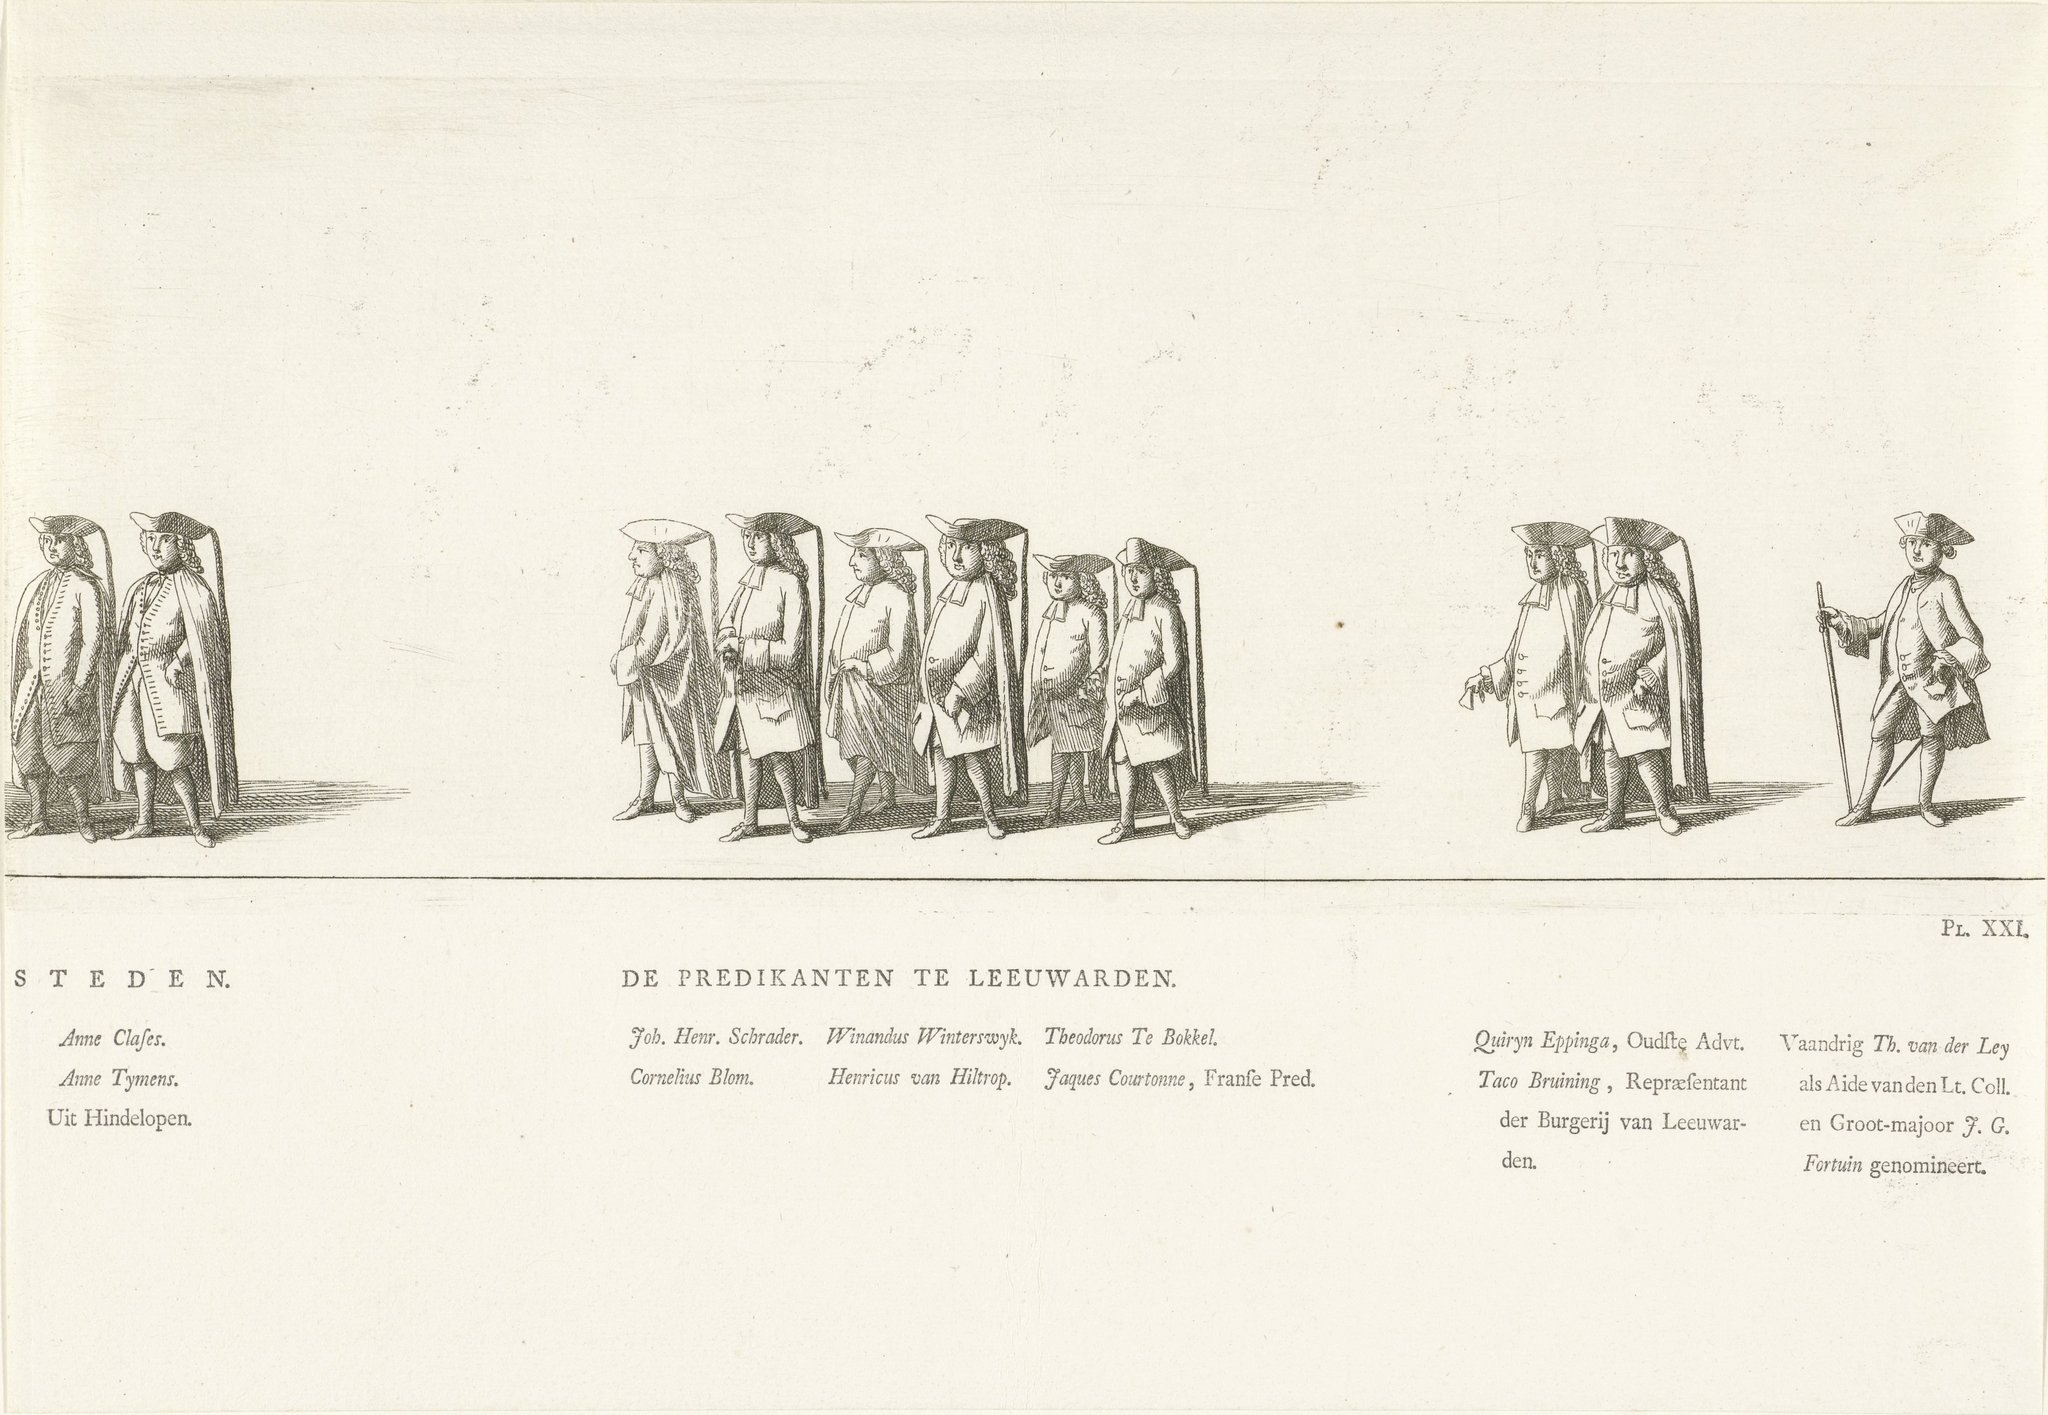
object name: print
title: Lijkstatie van prinses Maria Louise, 1765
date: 1765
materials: paper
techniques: etching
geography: leeuwarden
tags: cortege, funeral procession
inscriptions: collector's mark: Lugt 2228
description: De predikanten uit Leeuwarden. Gemerkt rechtsonder: Pl. XXI. Op het blad onder de plaat de namen van personen in de stoet. Onderdeel van de serie platen van de begrafenis van prinses Maria Louise te Leeuwarden op 13 juni 1765.